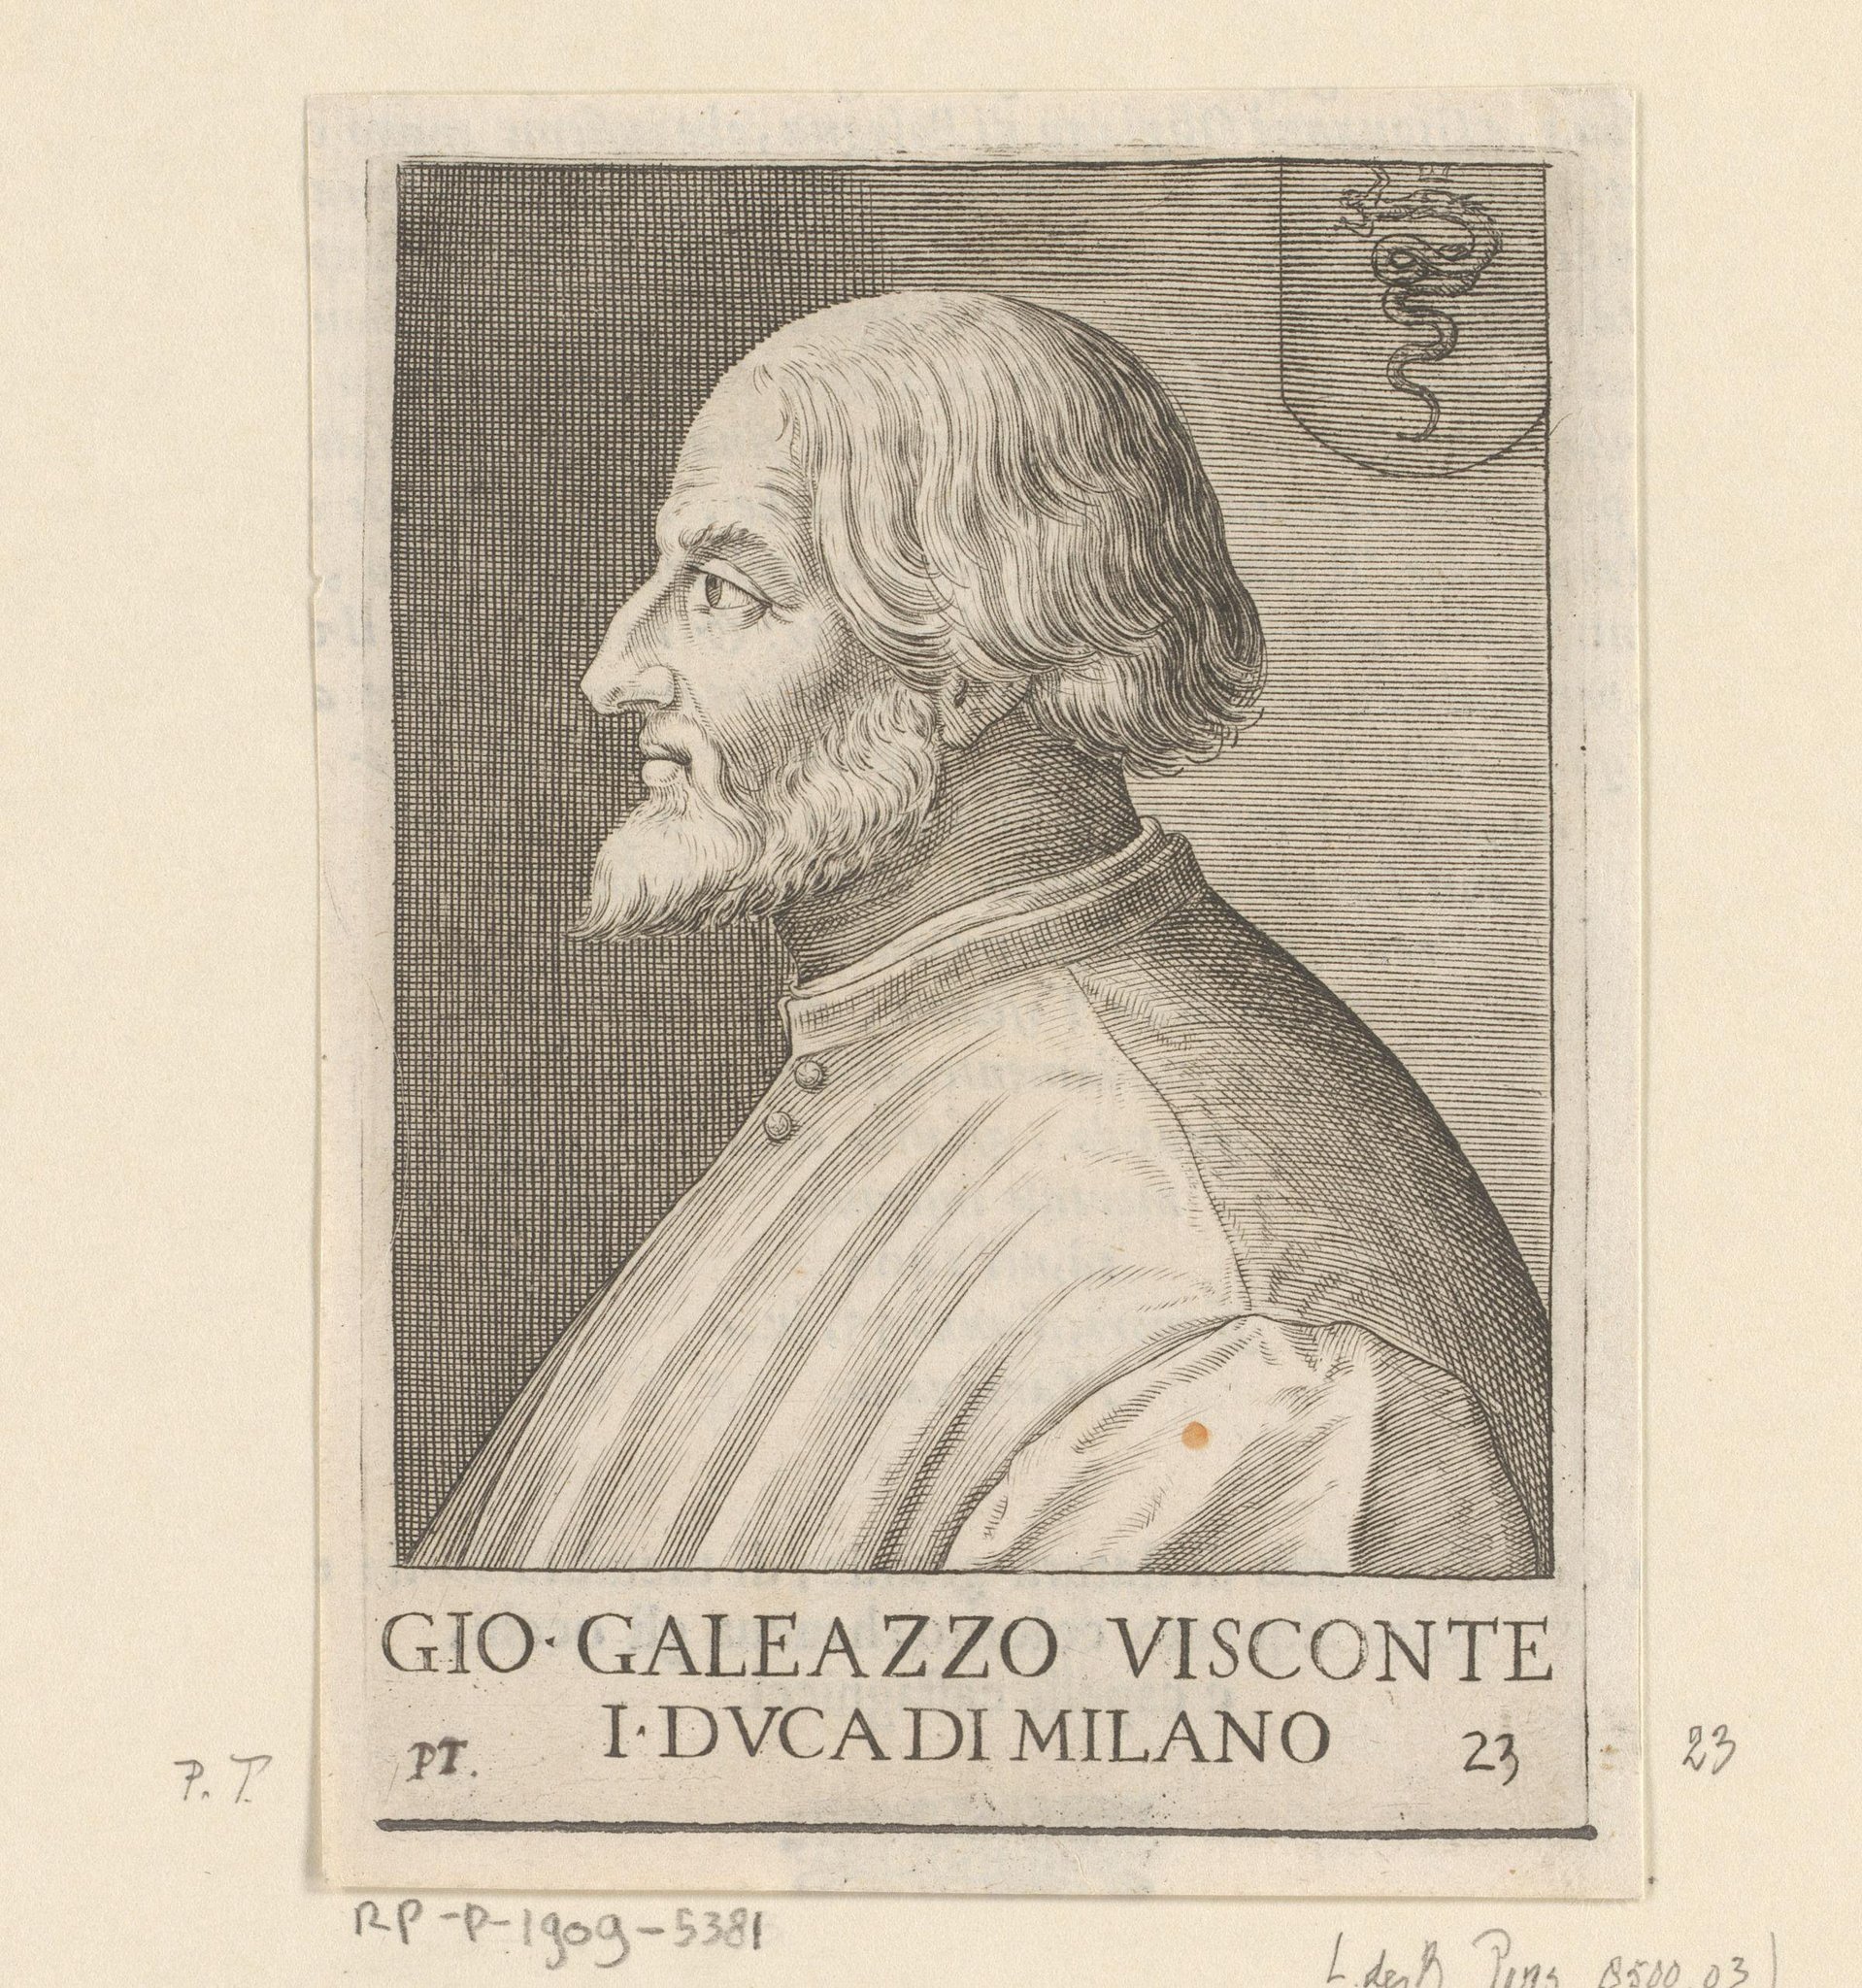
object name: book illustration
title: Portret van Gian Galeazzo Visconti, hertog van Milaan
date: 1635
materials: paper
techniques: engraving, letterpress printing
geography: rome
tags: historical persons, armorial bearing, heraldry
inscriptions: inscription: ‘PT.’, collector's mark: Lugt 2228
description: Prent uit: Ritratti et elogii di capitani Illustri. Rome: Pompilio Totti en Andrea Fei, 1635, p. 49. Eerdere staat van prent in ieder geval ook gebruikt in: Ritratti di cento capitani illustri con li lor Fatti in guerra (…), Rome: Domenico Gigliotti, 1596. Latere staat van prent in ieder geval ook gebruikt in: Ritratti et elogii di capitani Illustri. Che ne'secoli moderni hanno gloriosamente guerreggiato. Rome: Filippo de'Rossi en Vitale Mascardi, 1646.